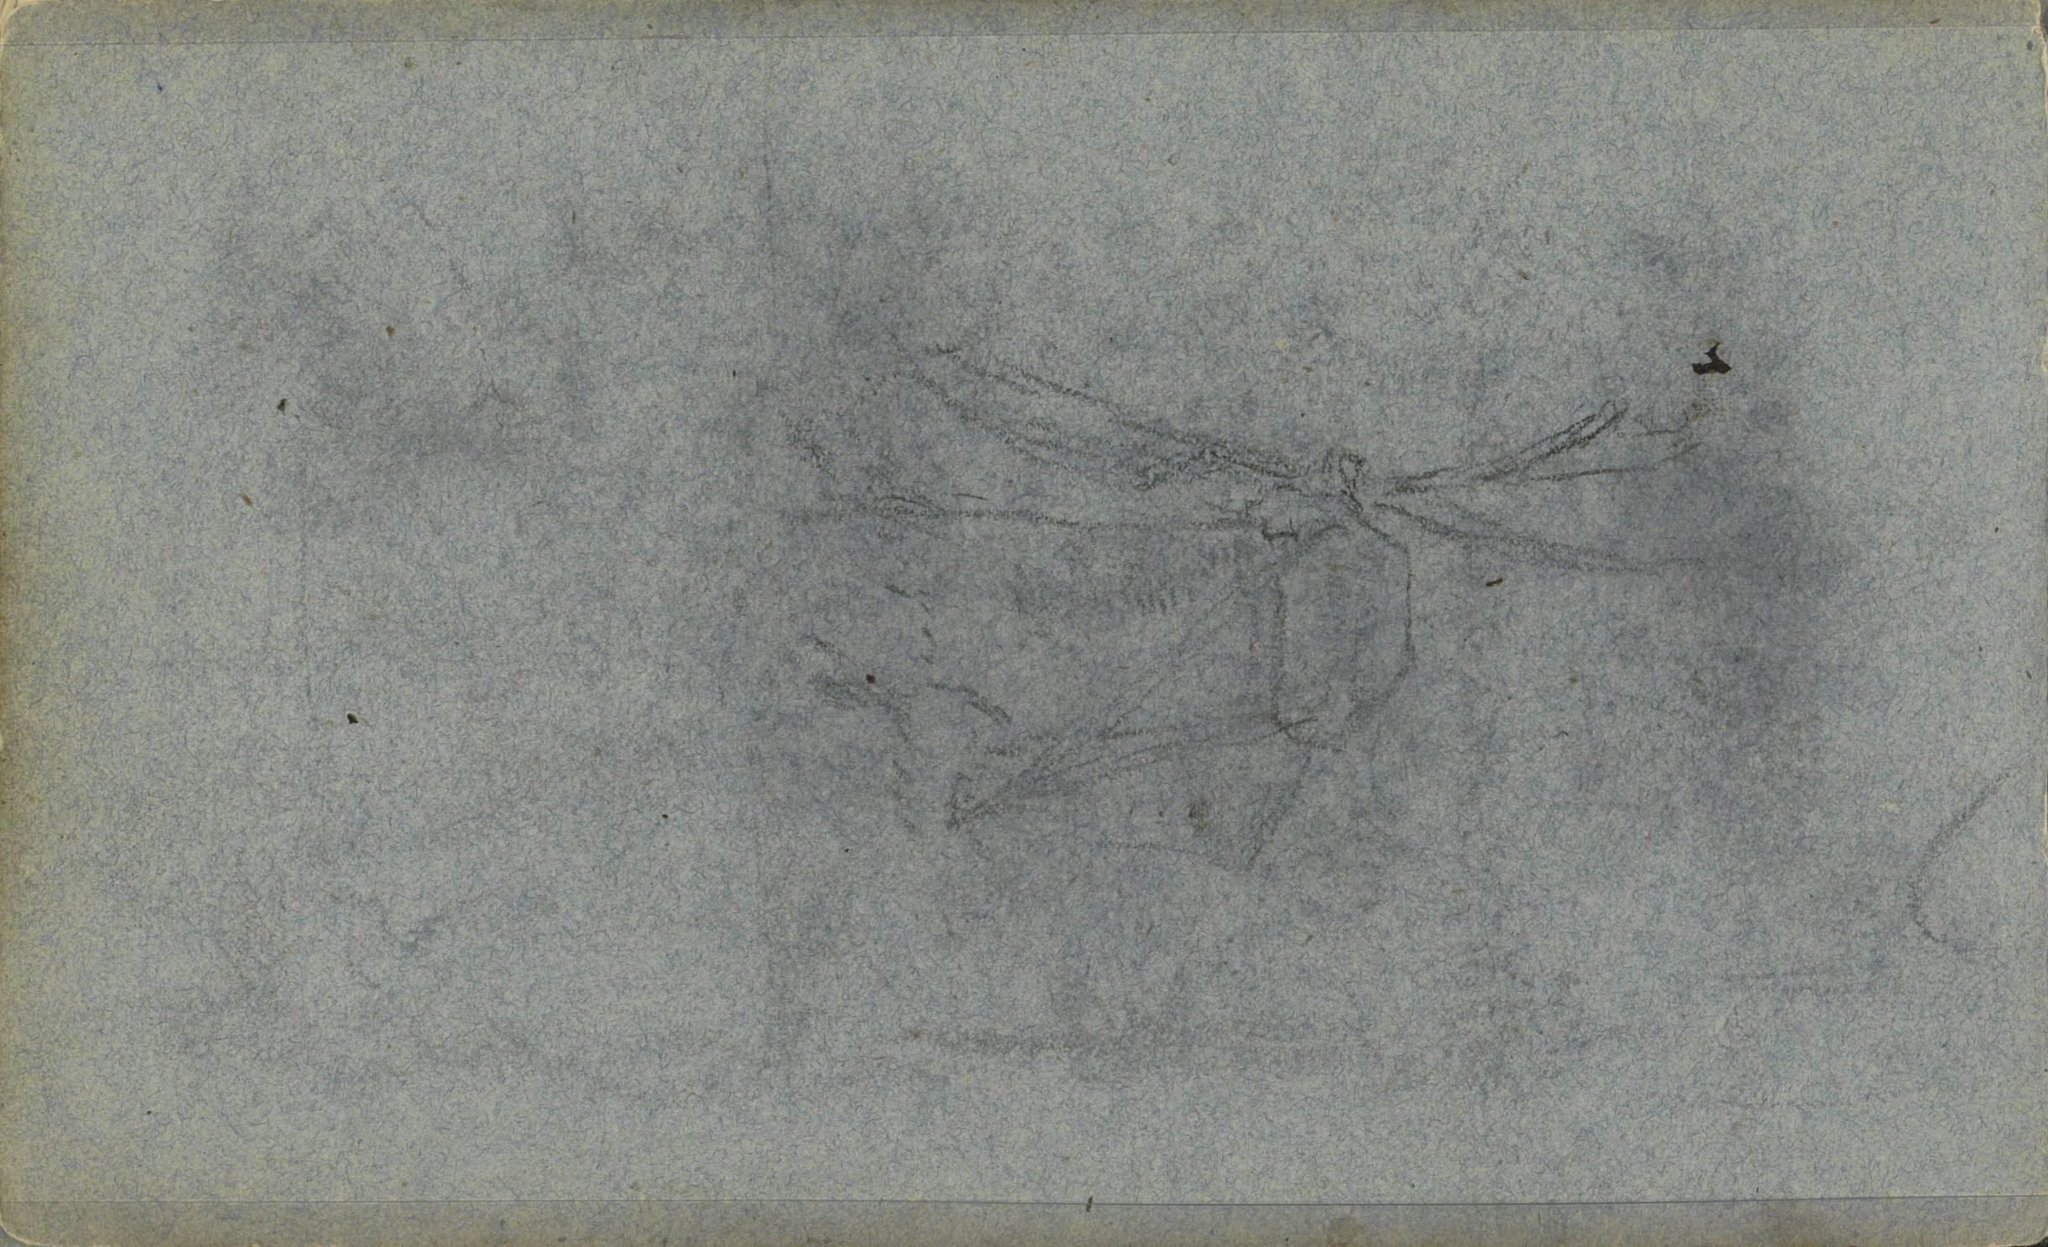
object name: sketchbook leaf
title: Molen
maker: jozef israëls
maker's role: draughtsman, painter, print maker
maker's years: 1824-1911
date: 1834-1911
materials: chalk, paper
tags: windmill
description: Blad 6 verso uit een schetsboek met 42 bladen.